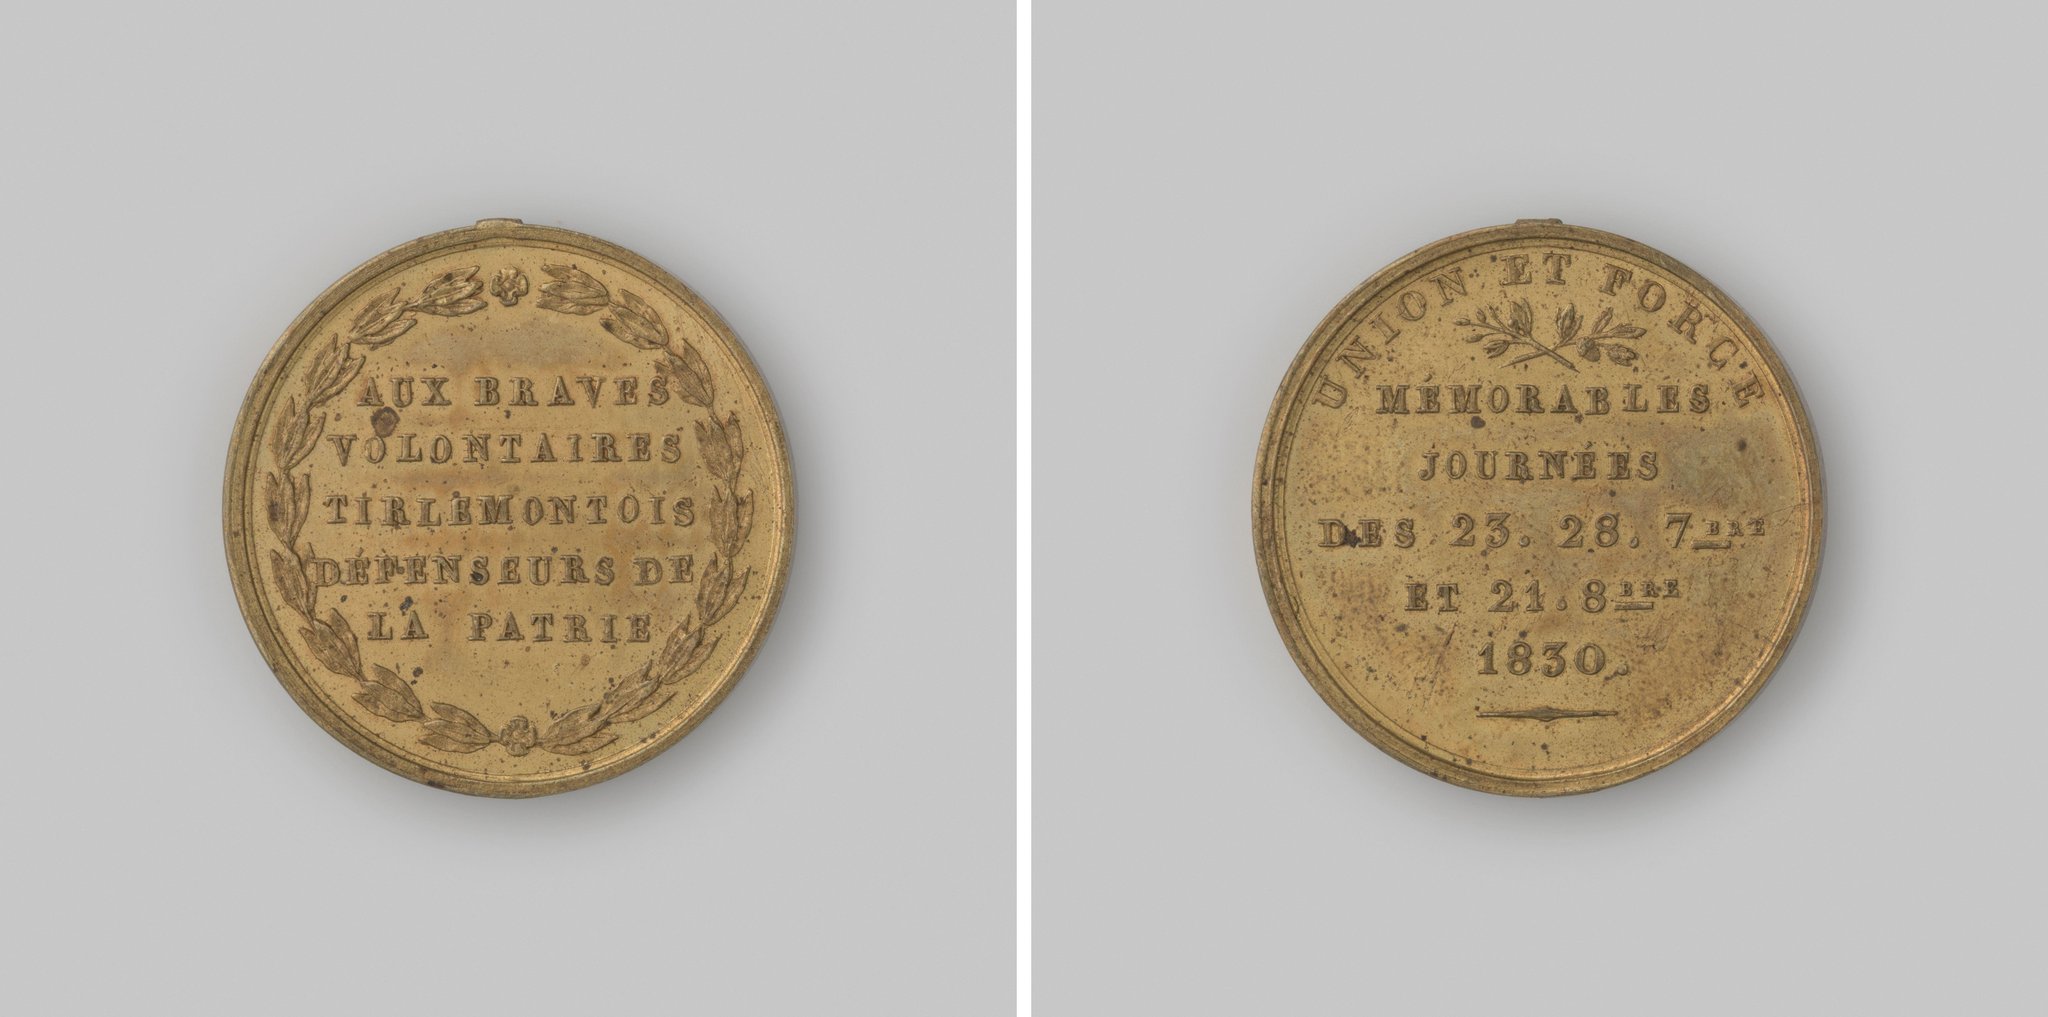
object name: history medal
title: De vrijwilligers van Tirlemont 1830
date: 1830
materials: brass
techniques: striking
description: Messing penning, op de voorzijde vijf regels tekst tussen twee lauwertakken, op de keerzijde zes regels tekst en een lauwer- en eikentakje.